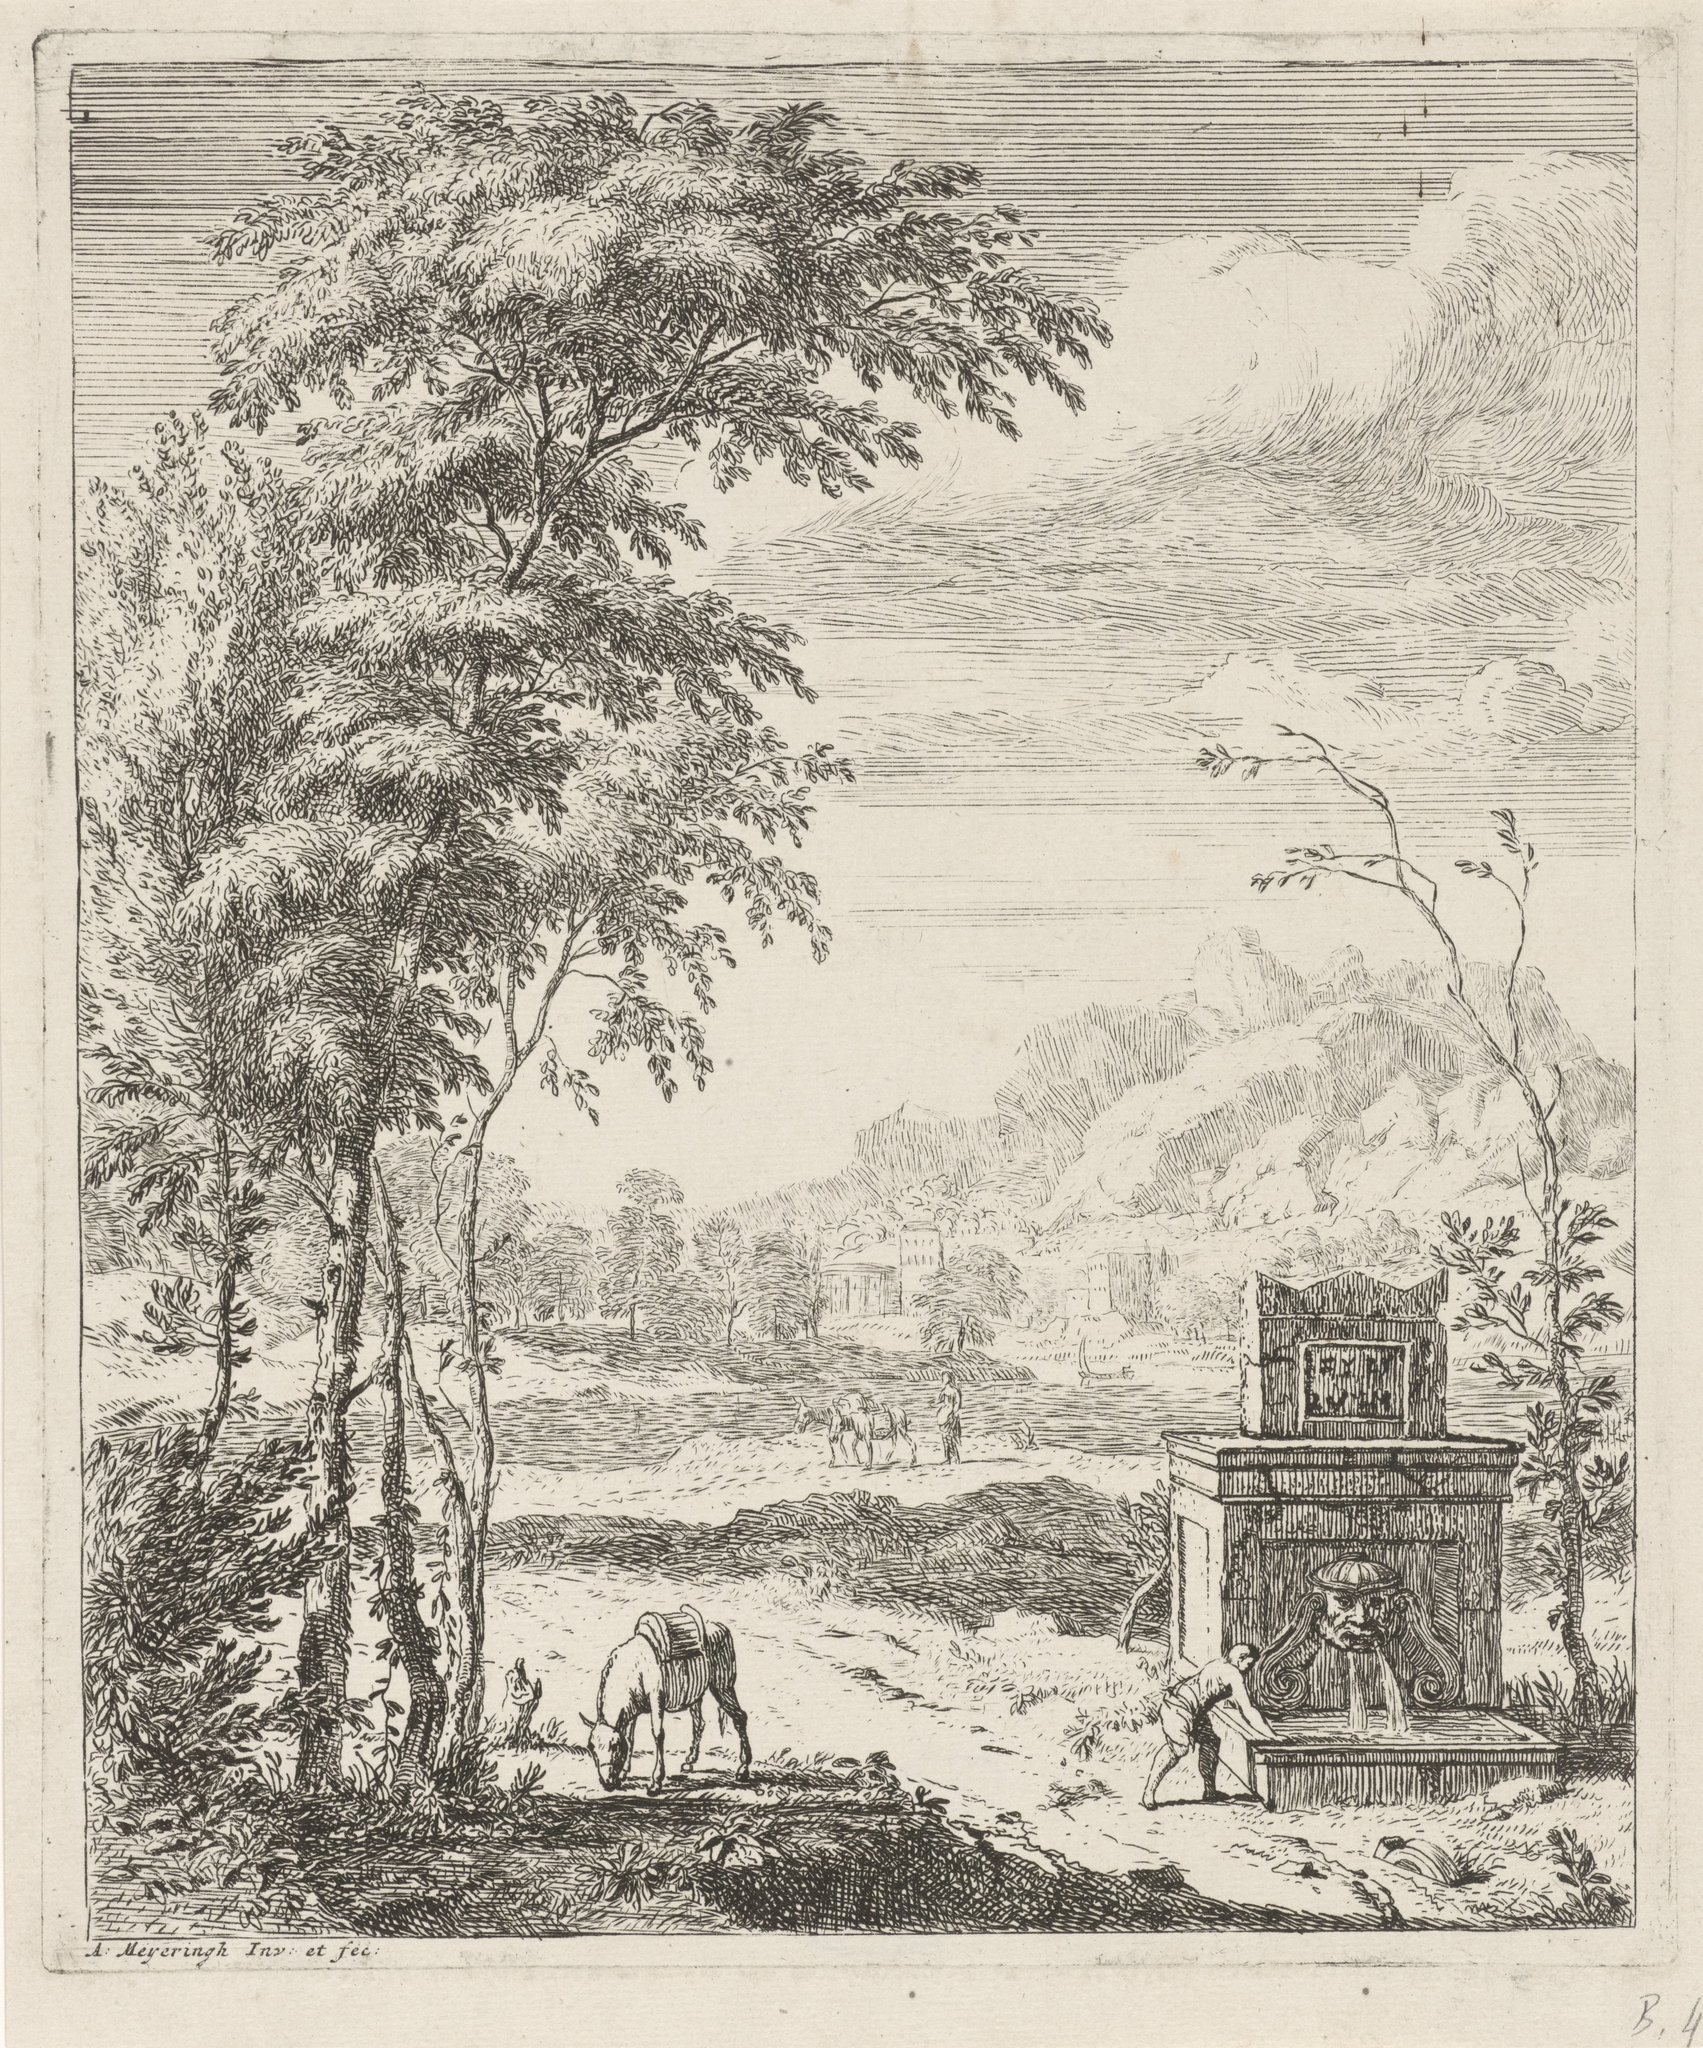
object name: print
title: Landschap met een fontein en een ezel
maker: albert meyering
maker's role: draughtsman, print maker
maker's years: 1645-1714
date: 1695-1714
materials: paper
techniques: etching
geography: amsterdam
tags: ass, donkey, utilitarian, public pump or water fountain, mountains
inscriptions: collector's mark: Lugt 2228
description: Landschap met een fontein, waarbij het water uit de muur in een bassin stroomt. Daarbij staat een man. Links een grazende ezel en op de achtergrond bergen.